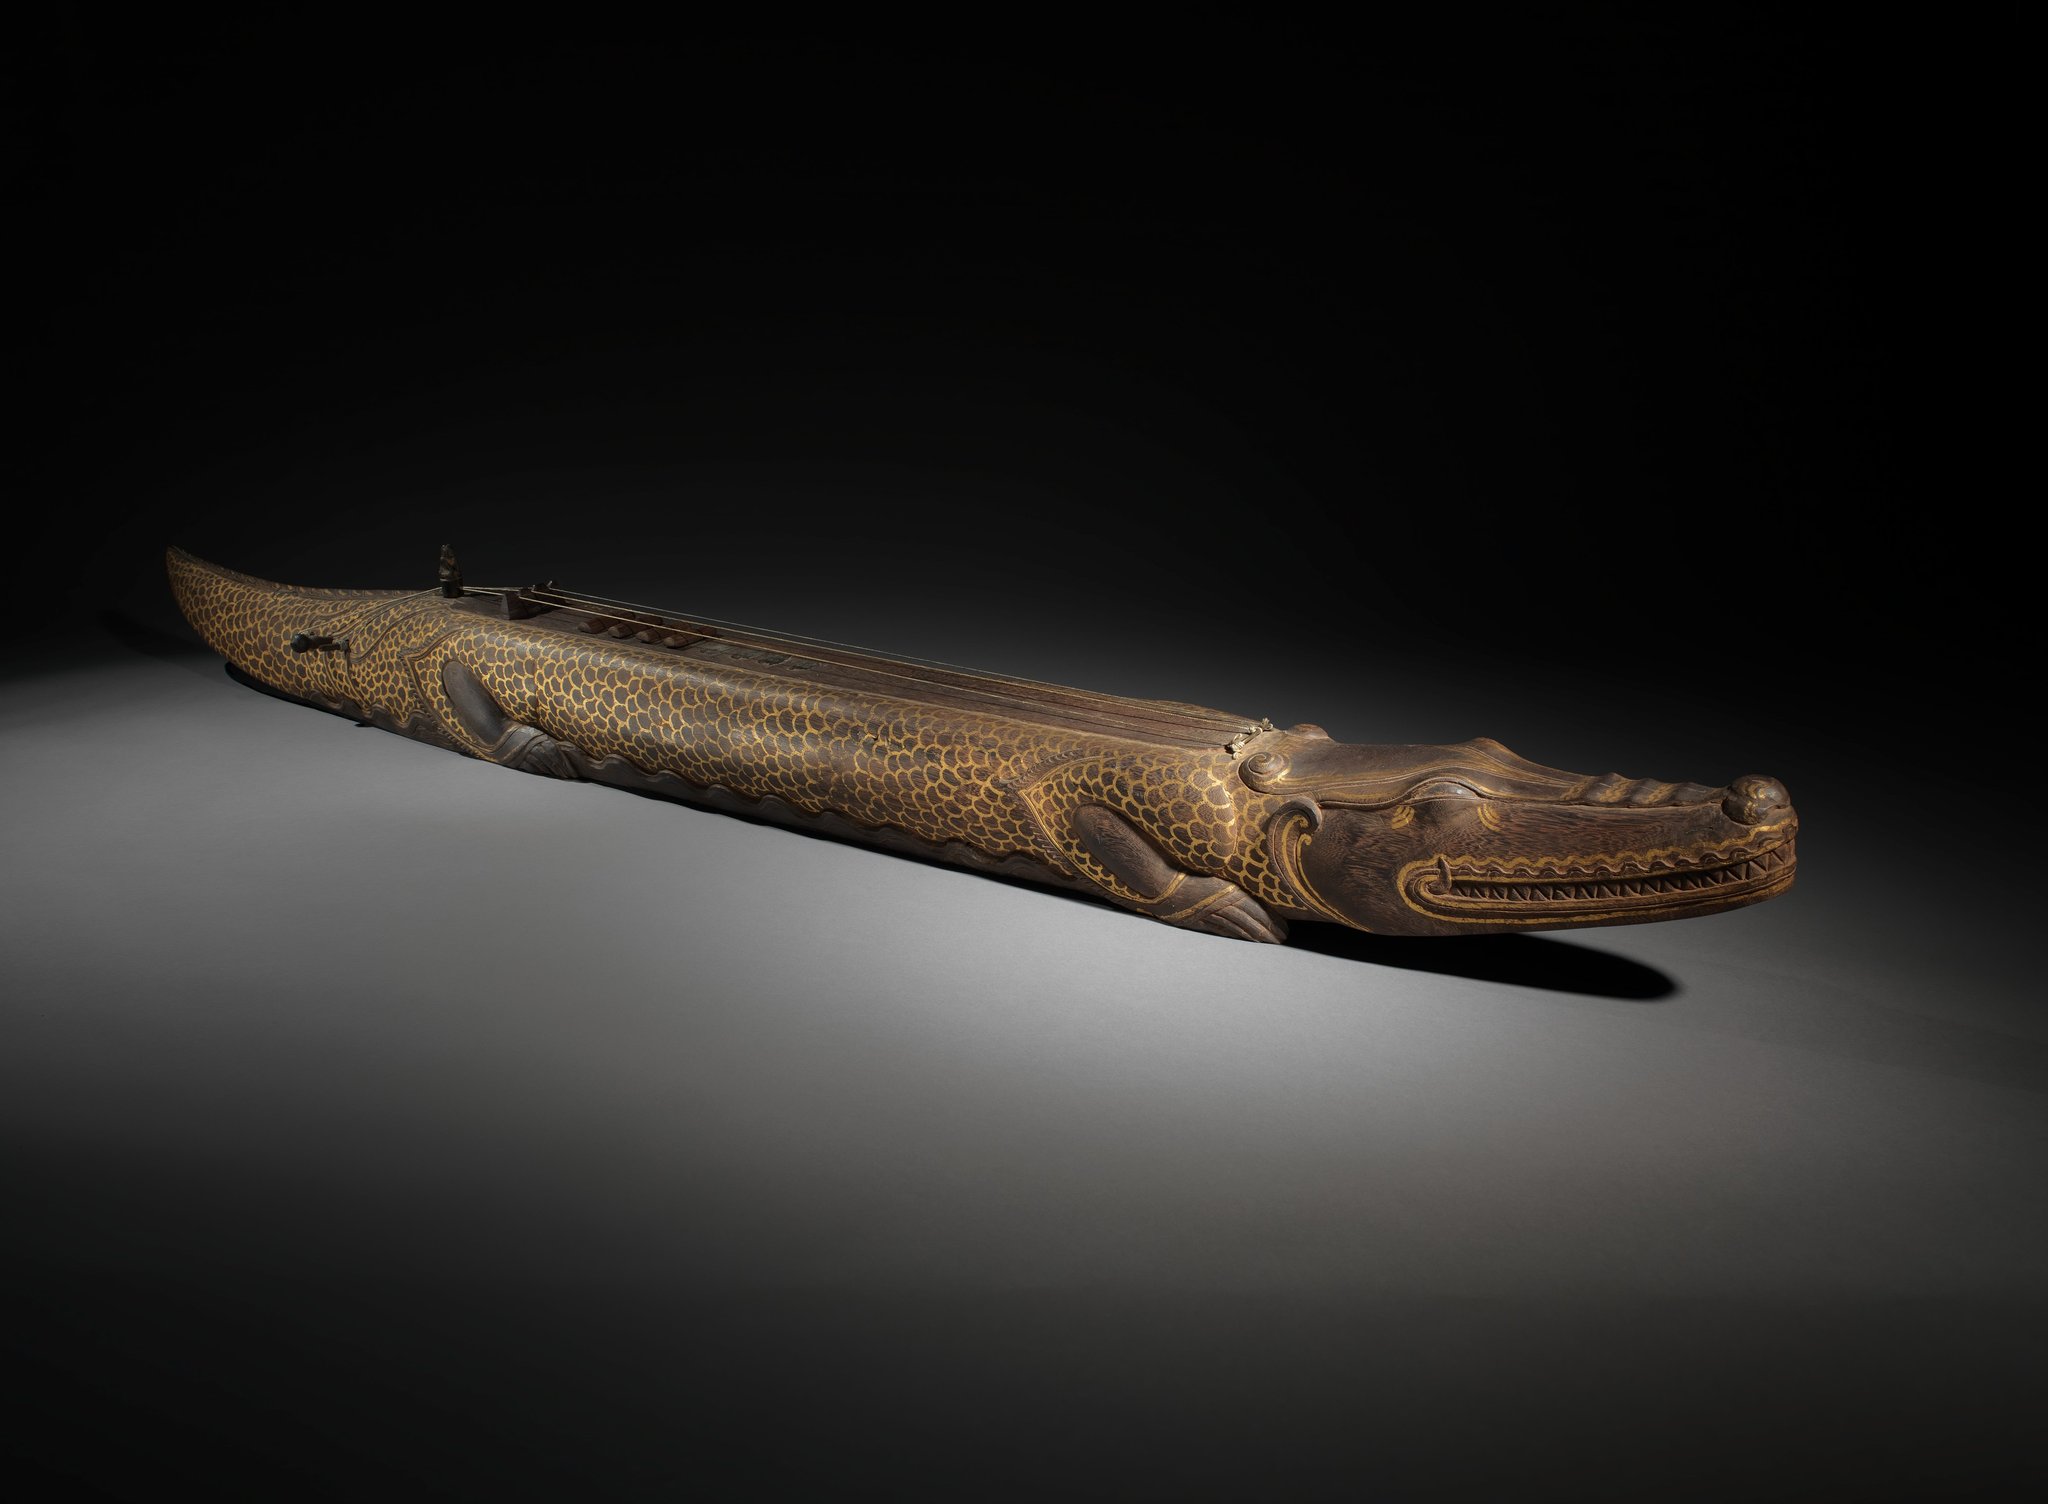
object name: mi gyaung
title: Mi-gyaung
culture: burmese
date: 1867-1900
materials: gold leaf, wood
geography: myanmar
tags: crocodiles